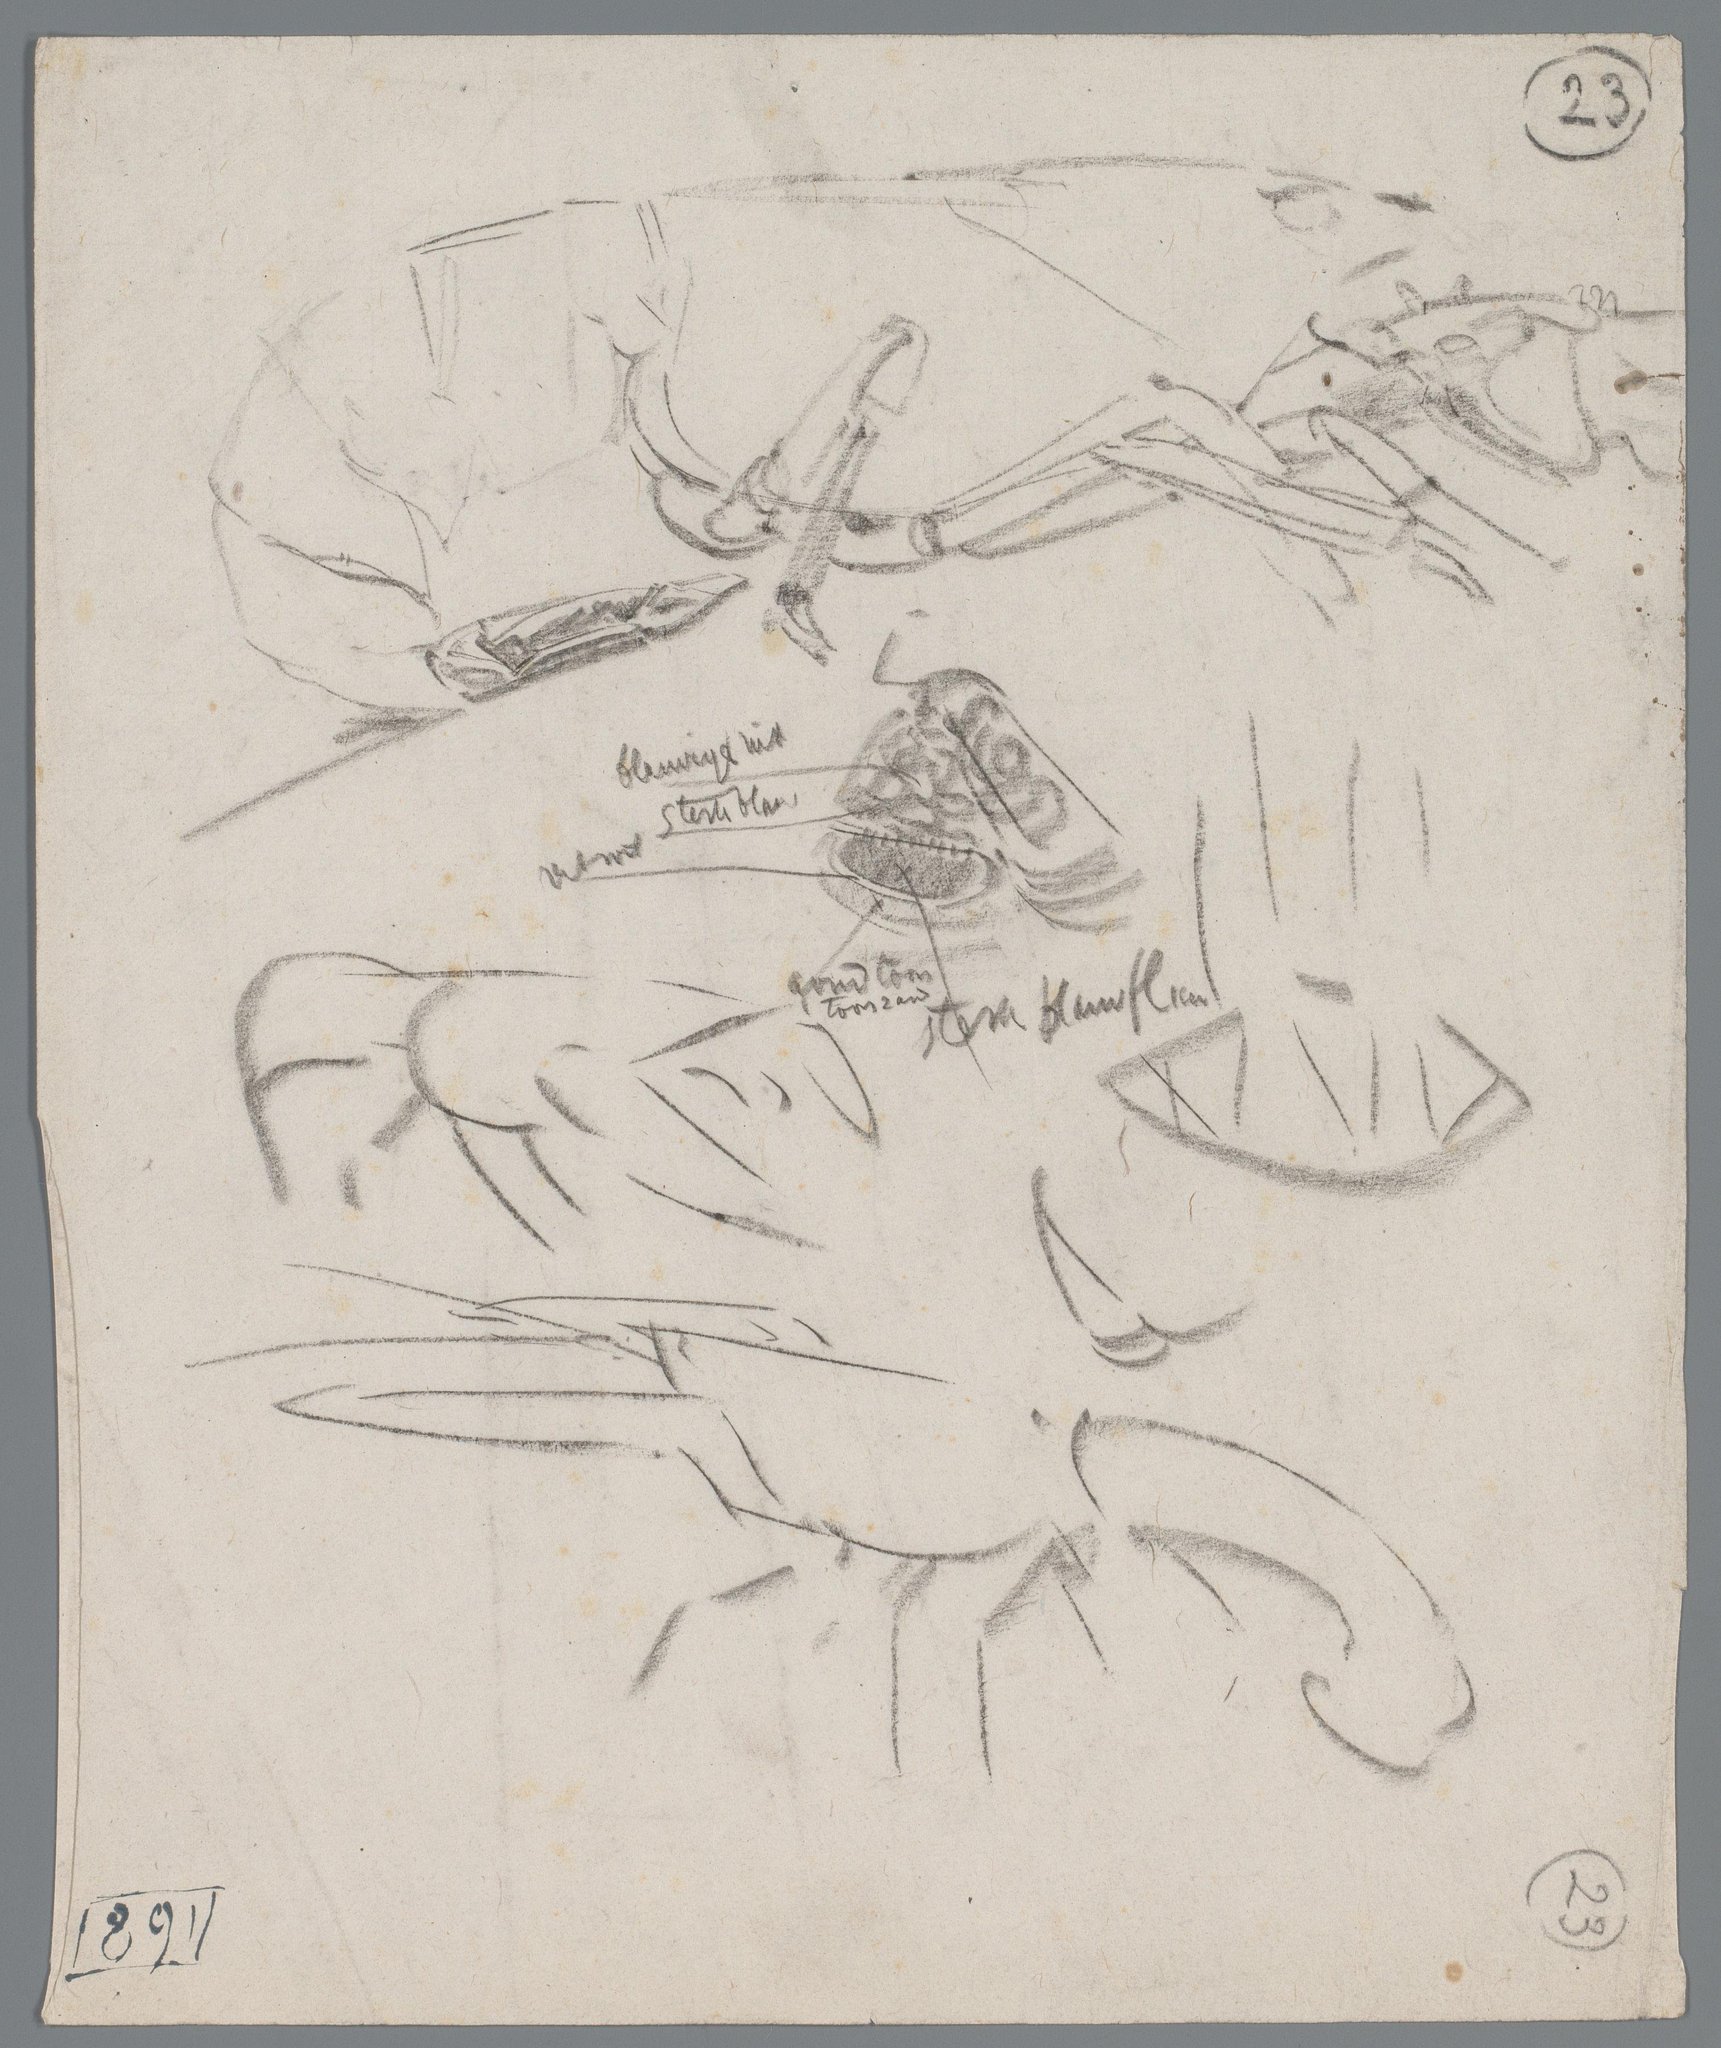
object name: drawing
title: Studies van kreeften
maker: gerrit willem dijsselhof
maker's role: designer, draughtsman, print maker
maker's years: 1866-1924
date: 1876-1924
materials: chalk, paper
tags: crustaceans: lobster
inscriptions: number: ‘891’, number: ‘23’